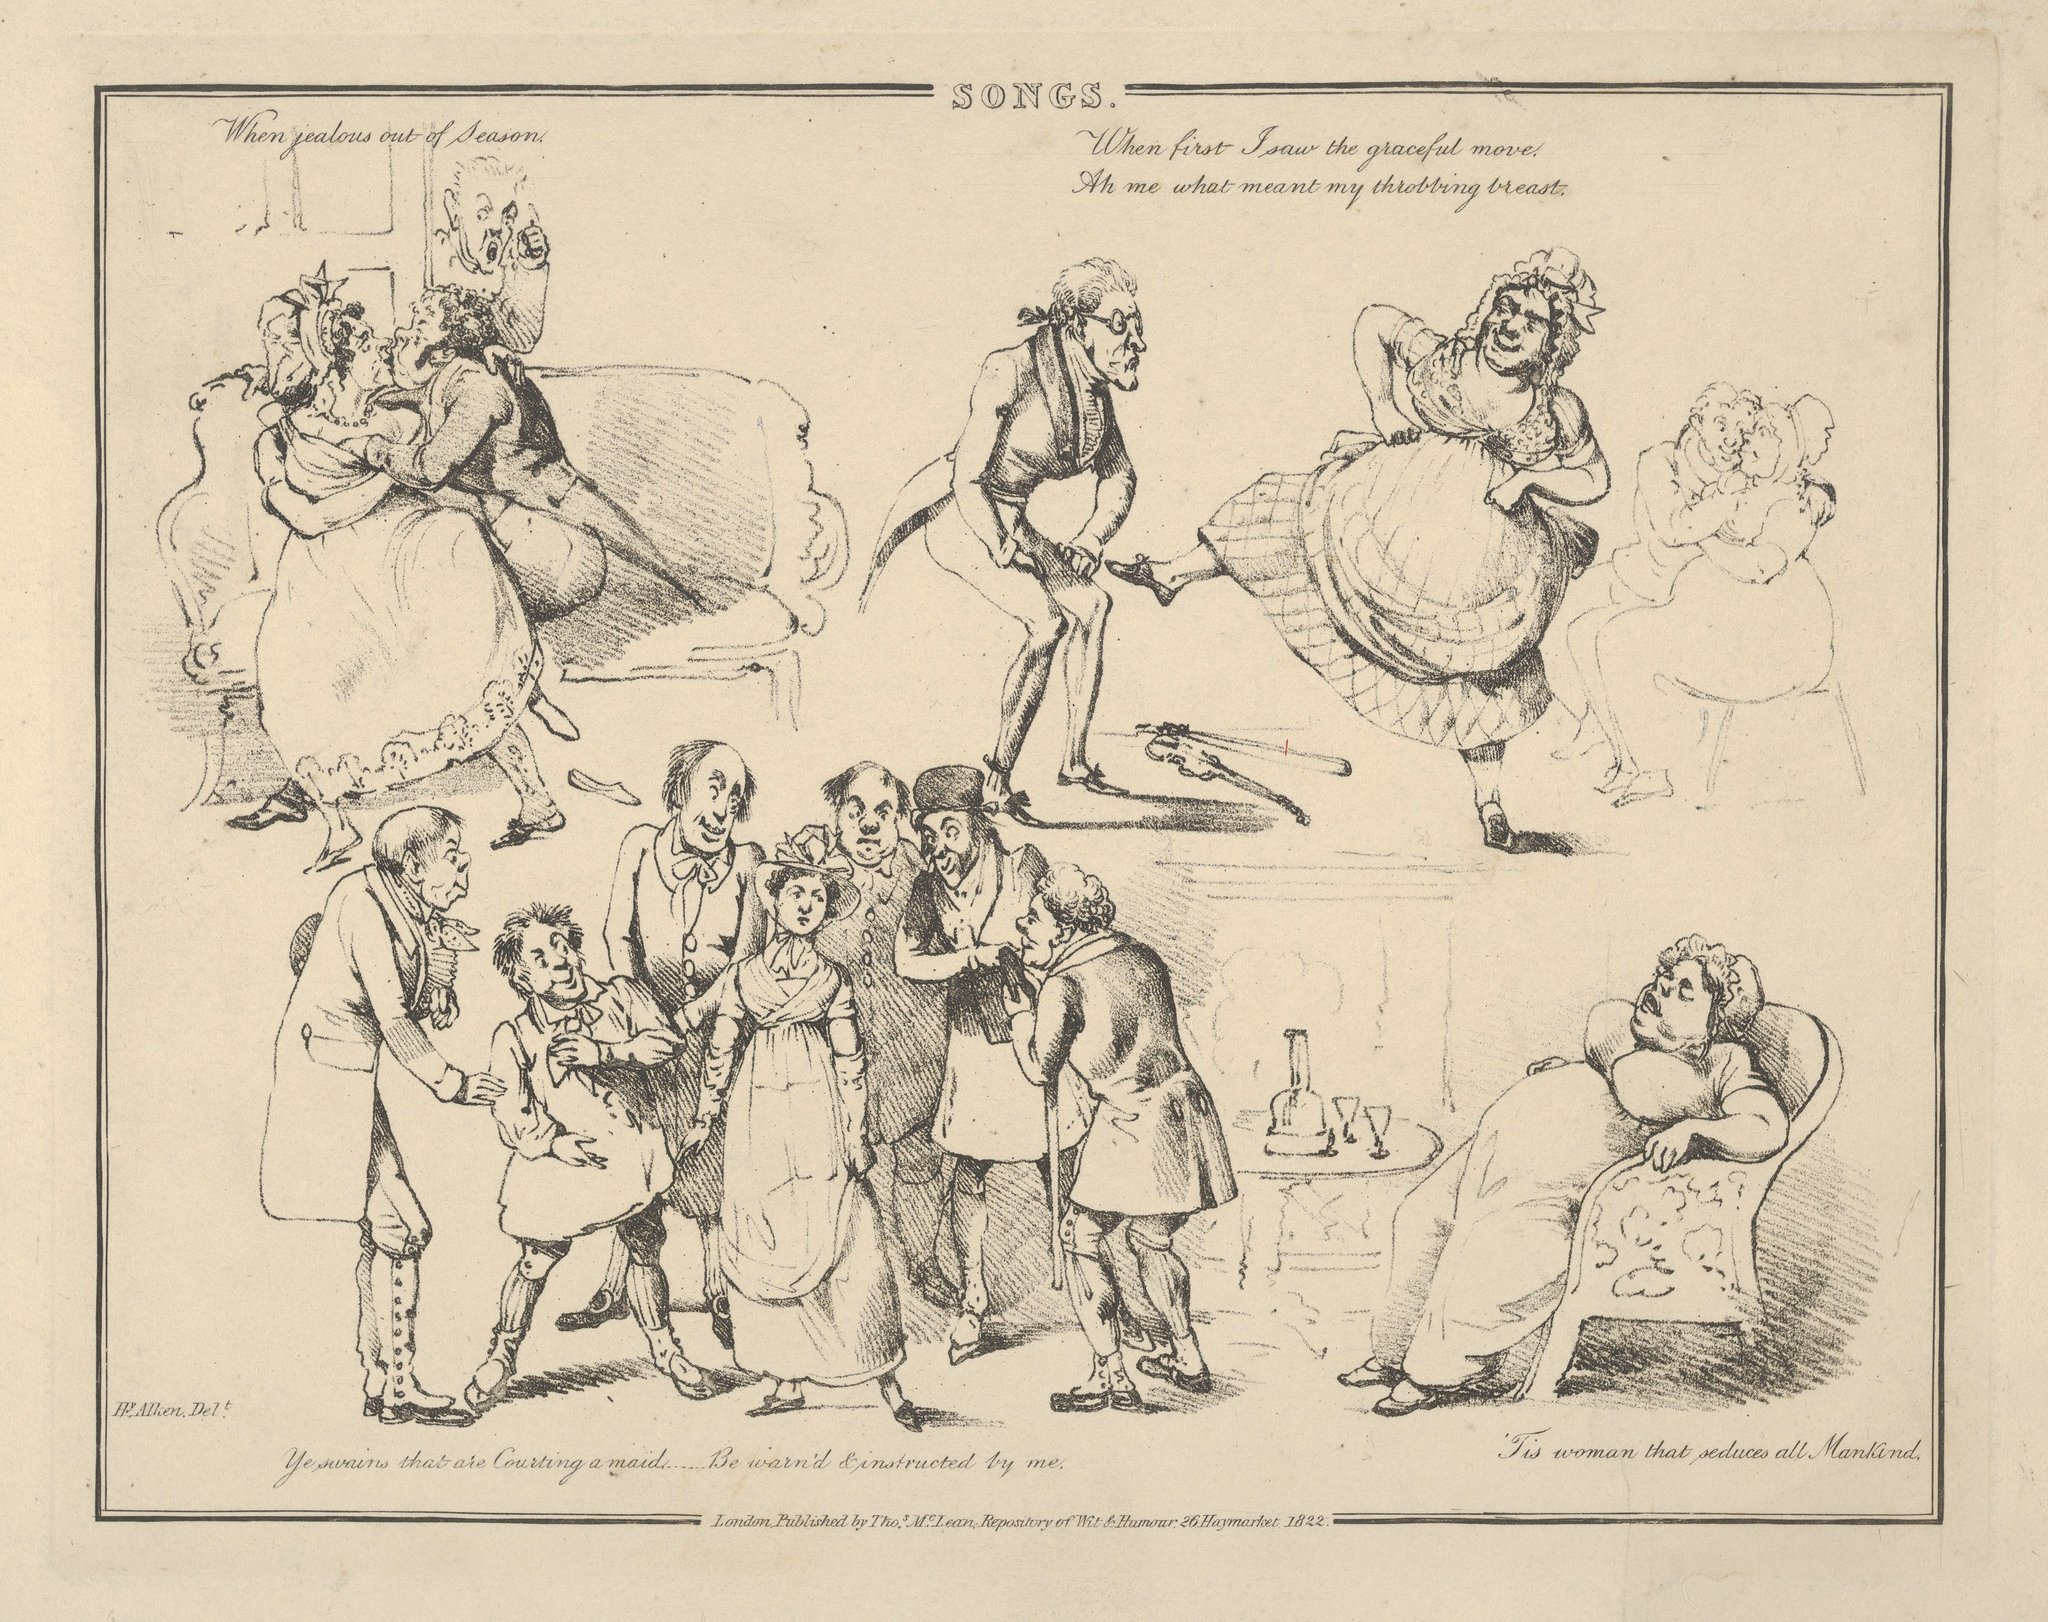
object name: print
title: Songs: "When jealous out of Season..."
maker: henry alken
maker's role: artist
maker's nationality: british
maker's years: 1785-1851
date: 1822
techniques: etching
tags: satire,men,women